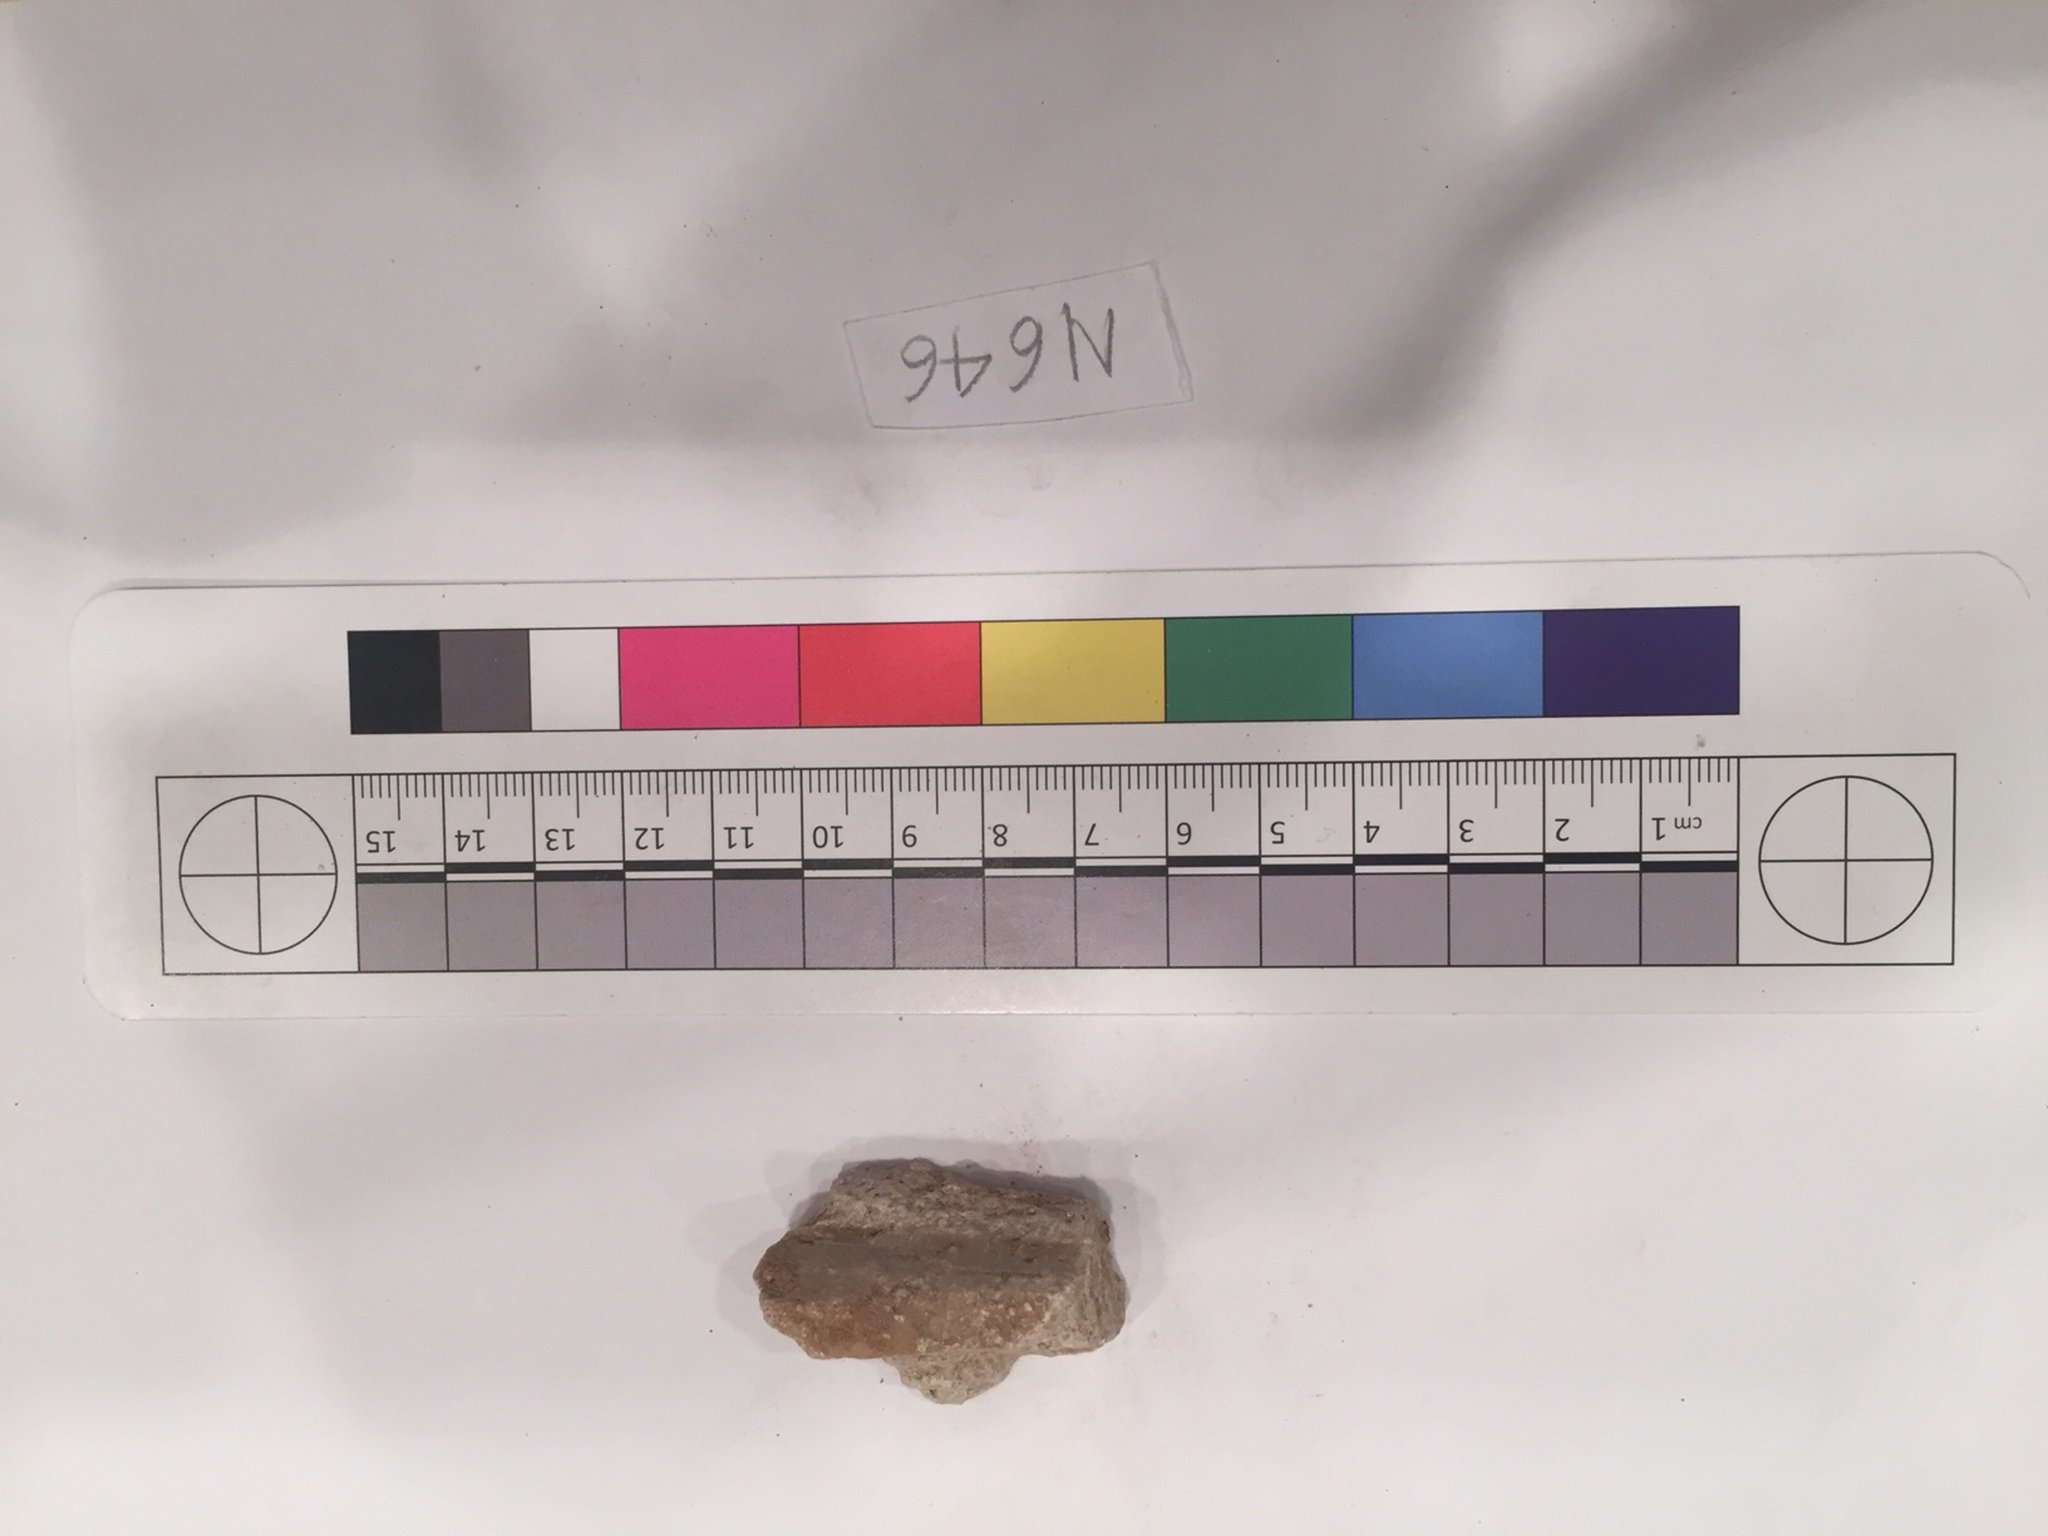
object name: fragment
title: Stucco Fragment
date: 701-1200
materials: plaster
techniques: carving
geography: iran